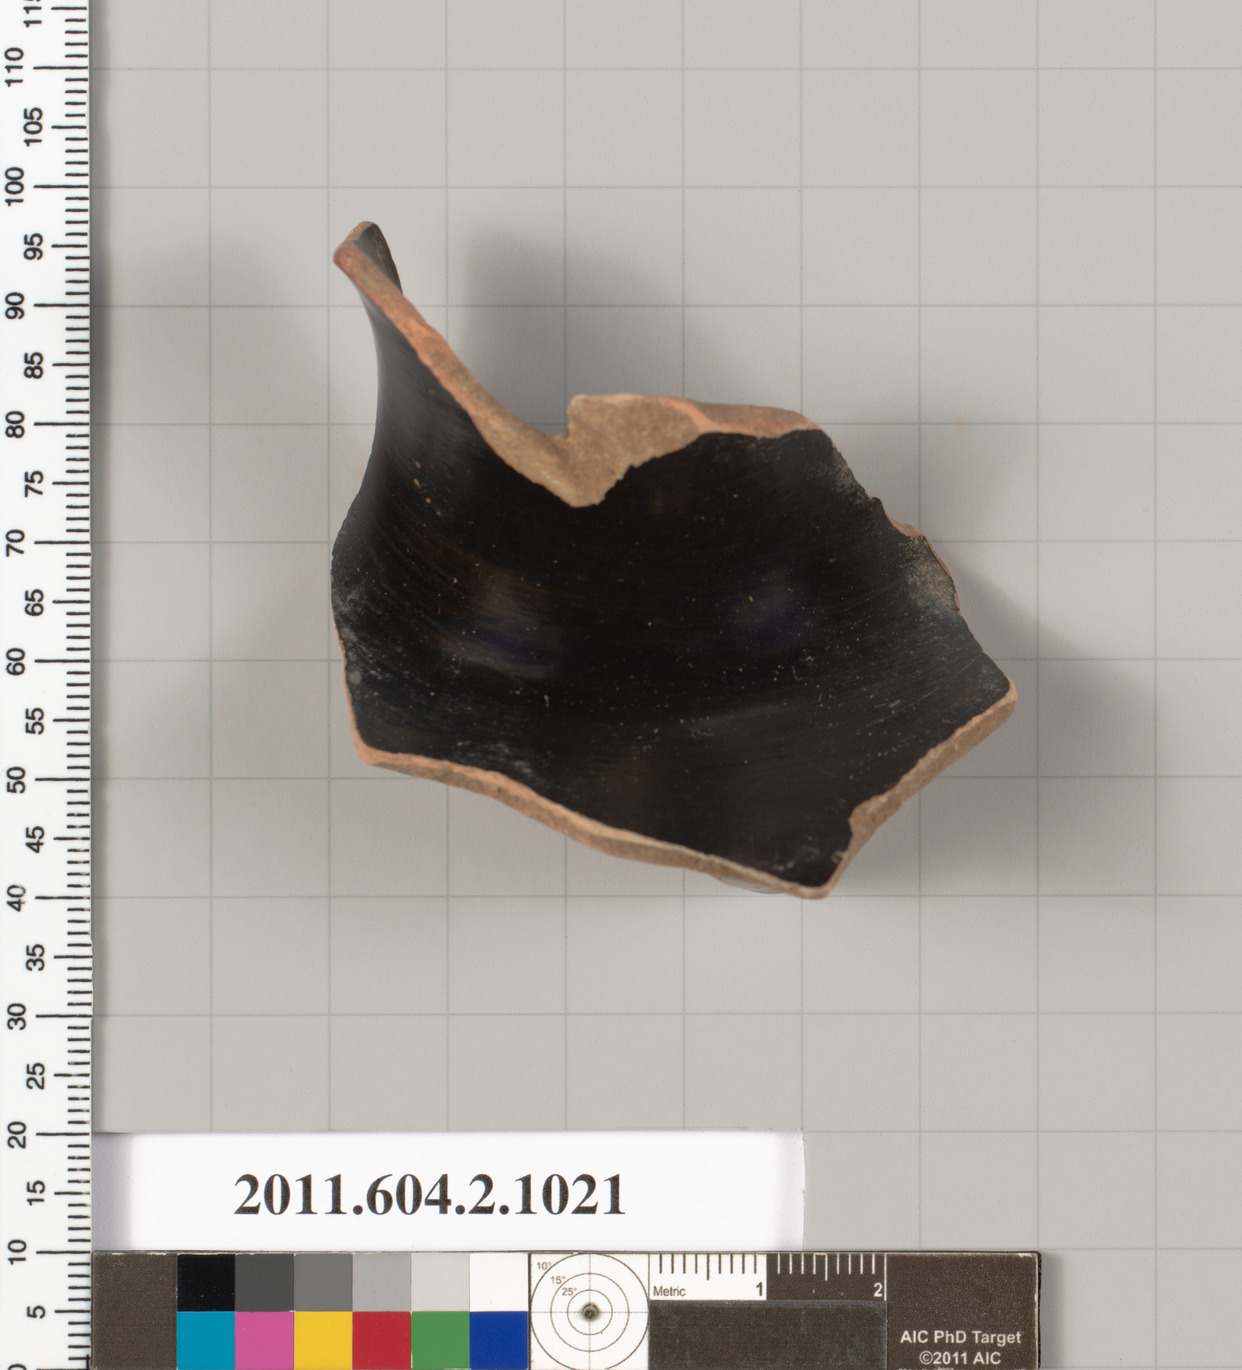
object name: oinochoe fragment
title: Terracotta fragment of an oinochoe (jug)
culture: greek, attic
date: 475-425 BCE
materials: terracotta